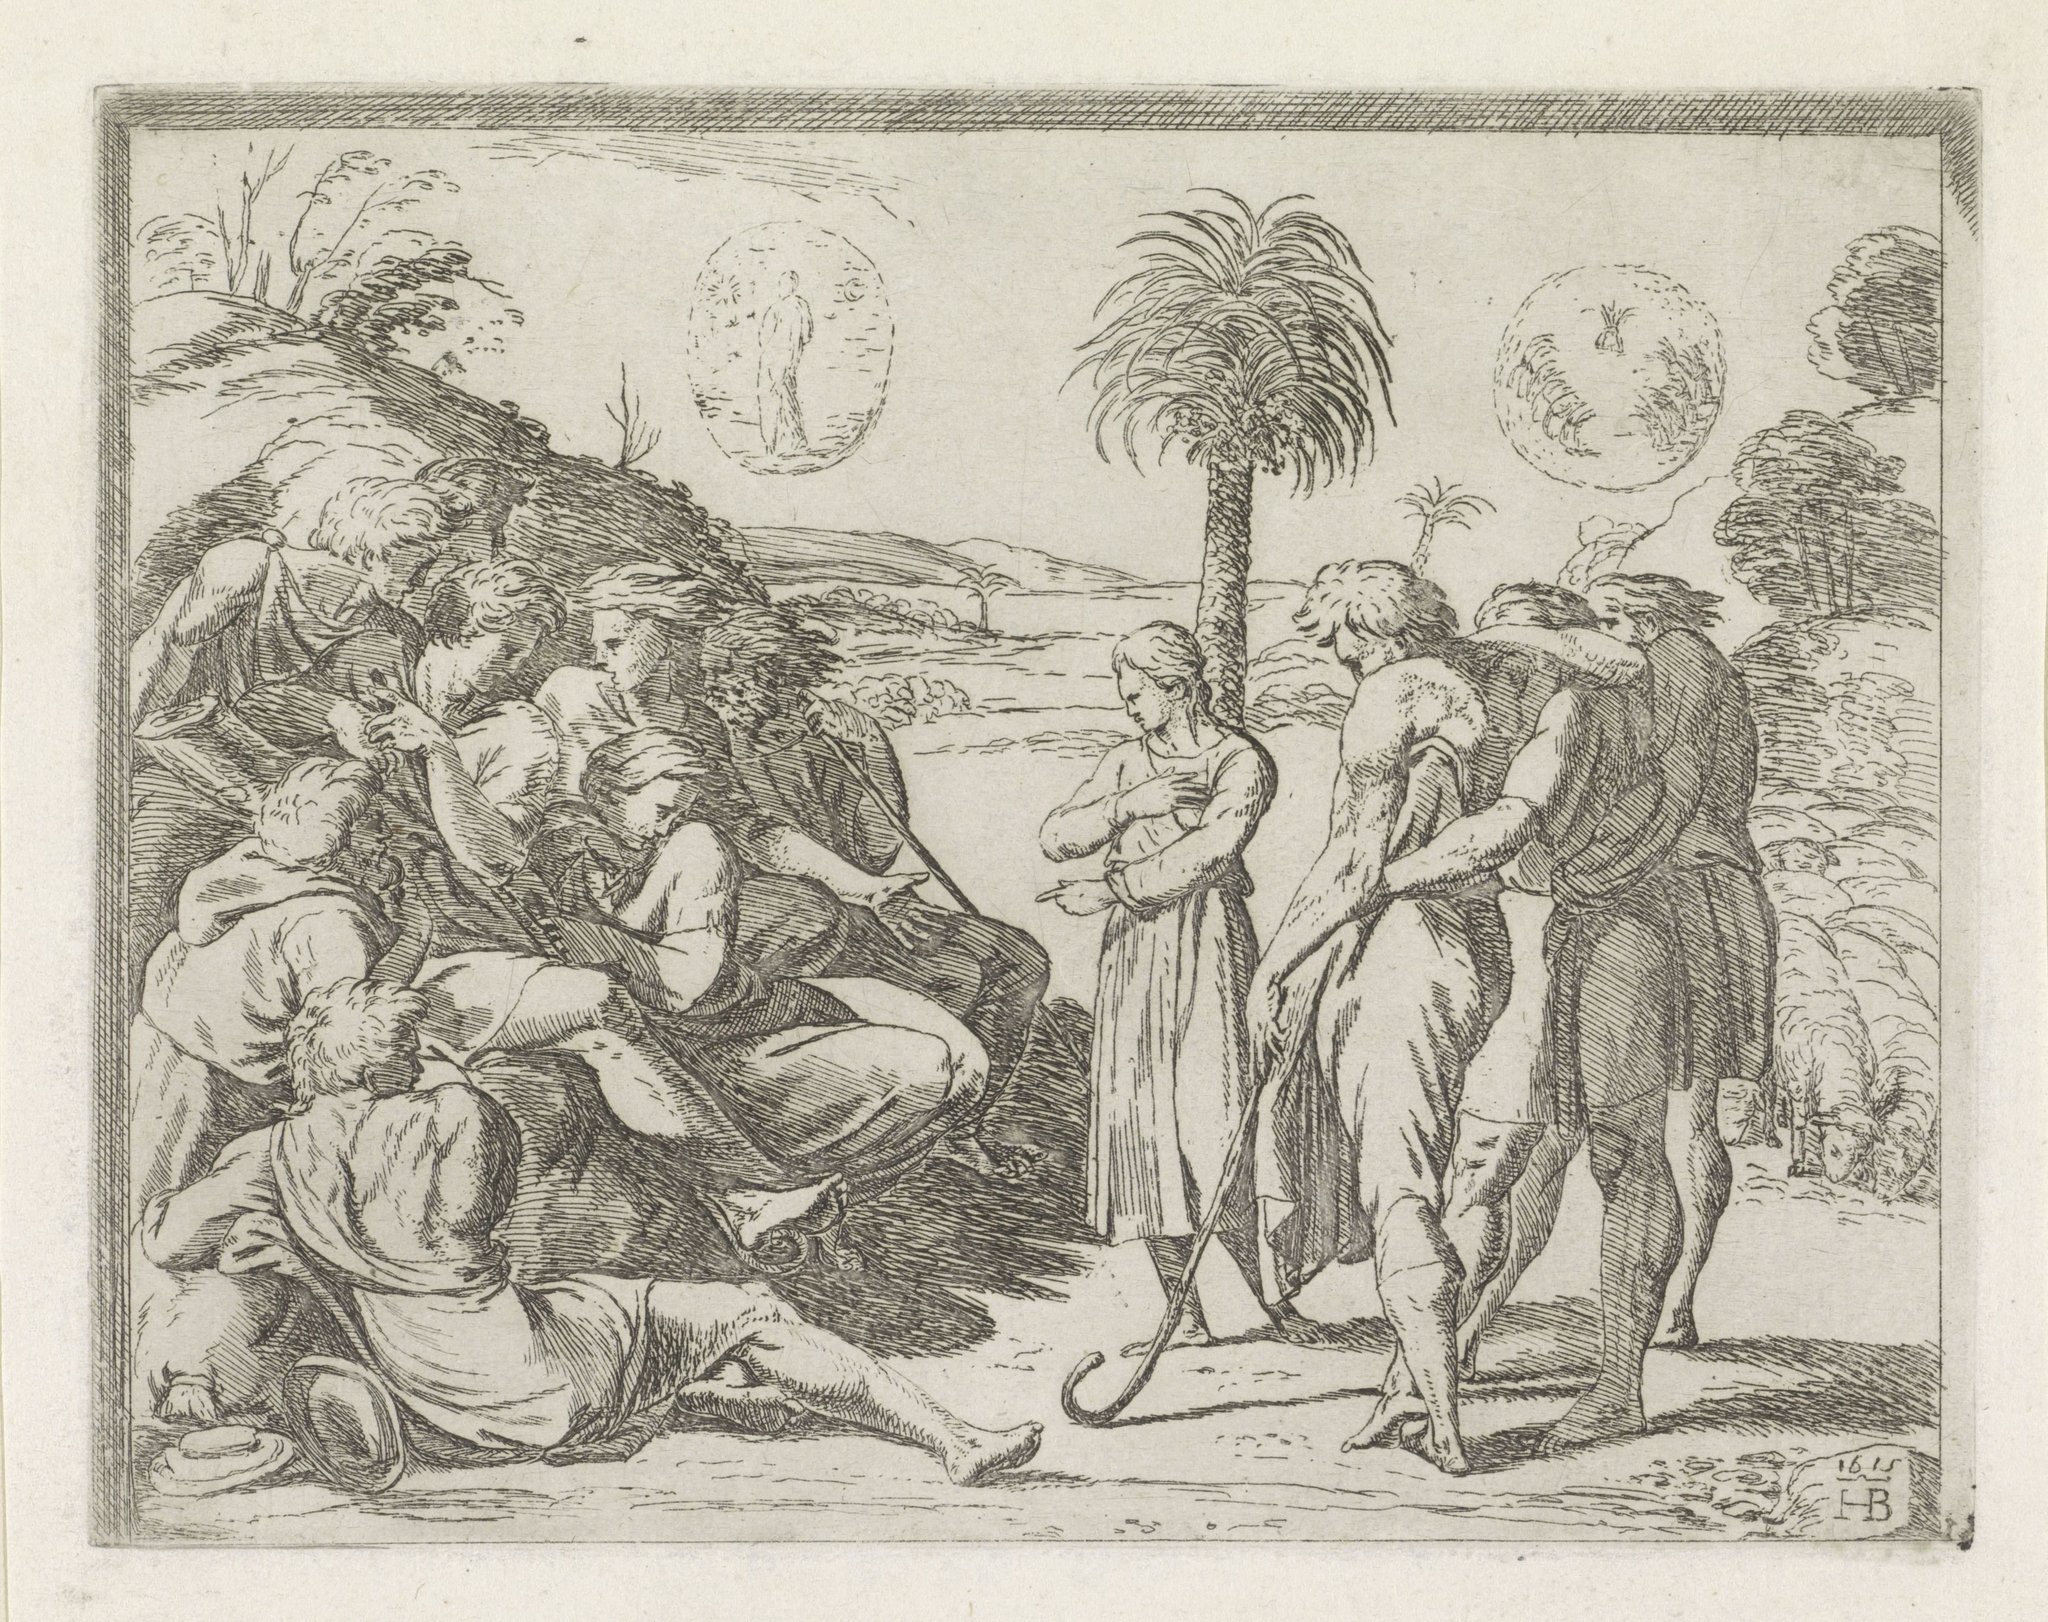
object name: print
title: Jozef vertelt zijn dromen aan zijn broers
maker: orazio borgianni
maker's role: print maker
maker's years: 1578-1616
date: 1615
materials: paper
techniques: etching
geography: vatican city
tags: story of joseph (part i), first dream of joseph: the eleven sheaves of wheat of his brothers form a circle round joseph's sheaf and bow down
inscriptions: collector's mark: Lugt 2165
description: Jozef legt zijn droom uit aan zijn broers. Hij vertelt dat in zijn droom de korenschoven van zijn broers bogen voor zijn eigen schoof en dat ook de zon, maan en sterren voor hem bogen.